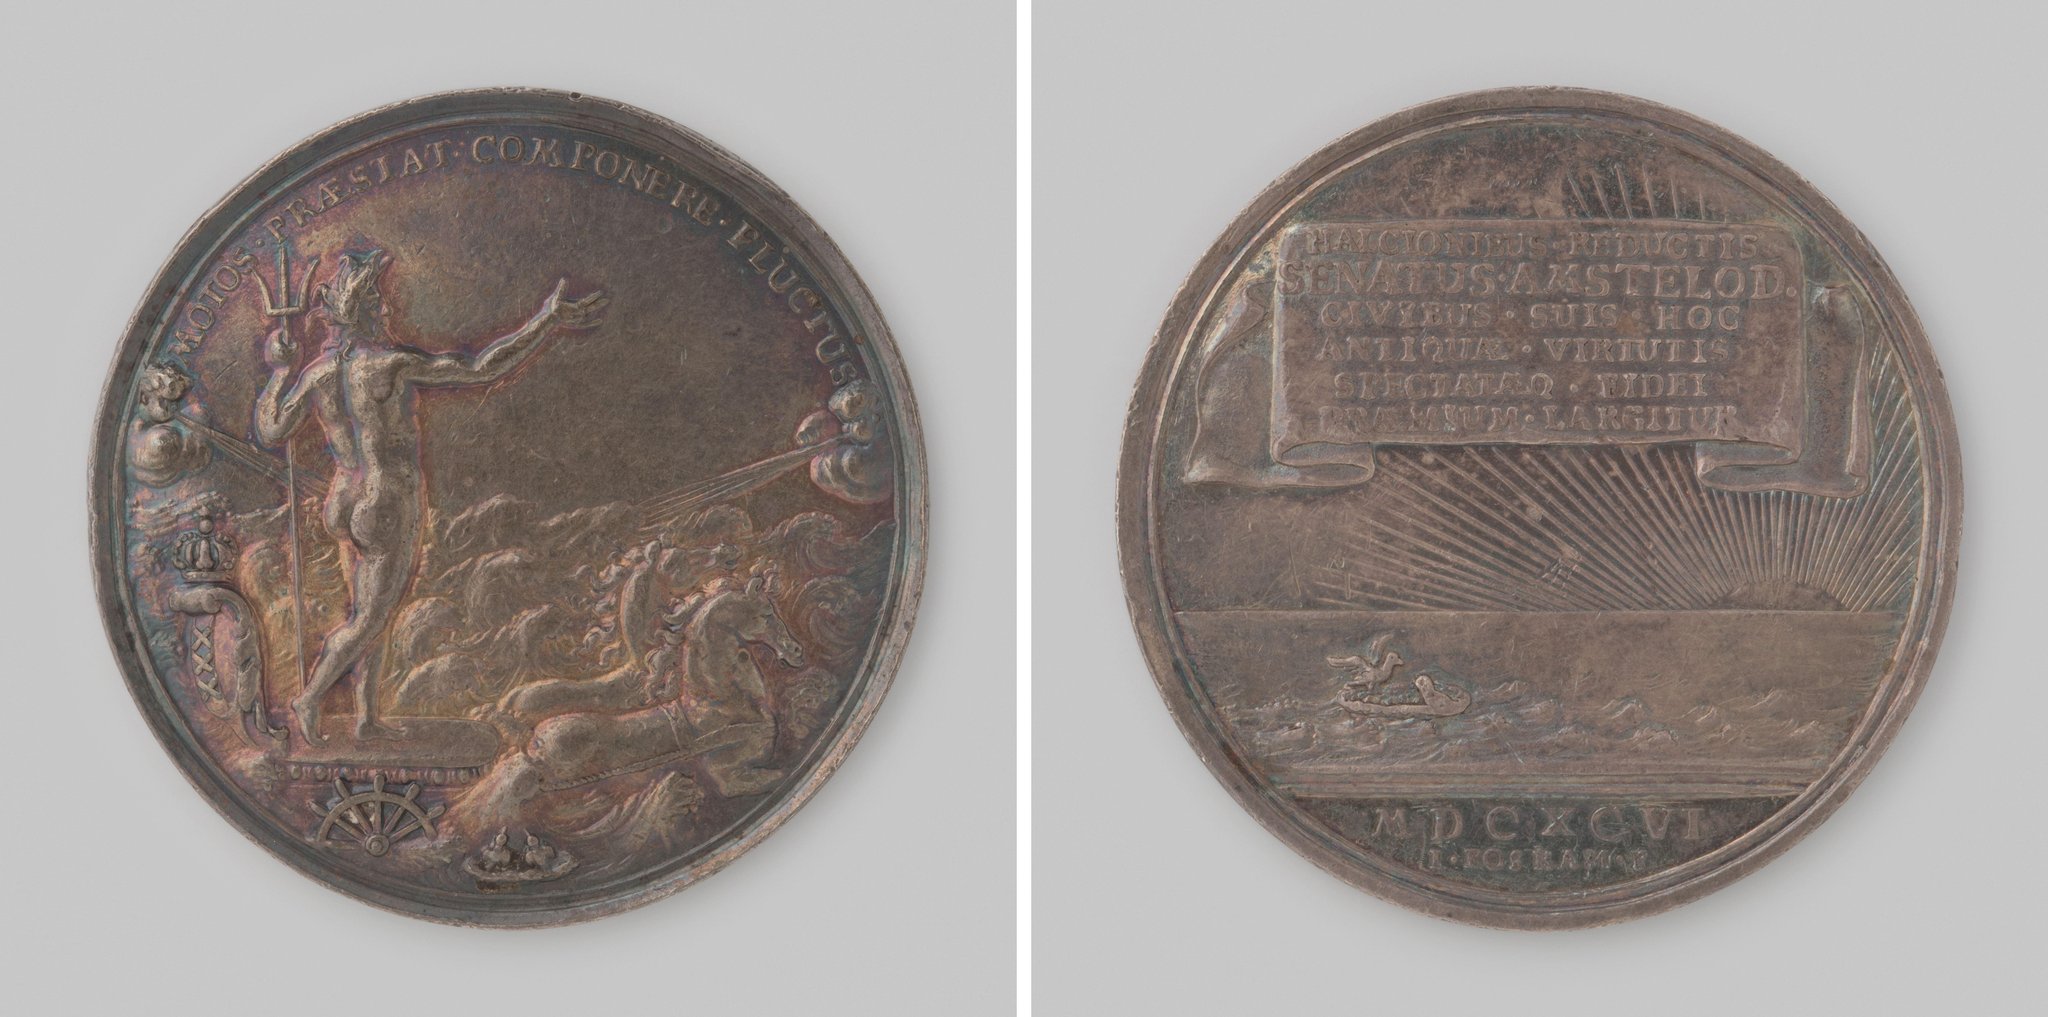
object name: history medal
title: Beloningspenning voor het neerslaan van het aansprekersoproer in Amsterdam 1696 (middelgroot model)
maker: jan boskam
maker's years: 1687-1708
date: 1696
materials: silver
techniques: striking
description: Zilveren penning, op de voorzijde Neptunus in strijdwagen op zee tussen twee windgoden, met omschrift, op de keerzijde een vredige zee waarop een vogelnest, met bovenaan een tekstvlag en in afsnede XDCXCVI / I. BOSKAM F